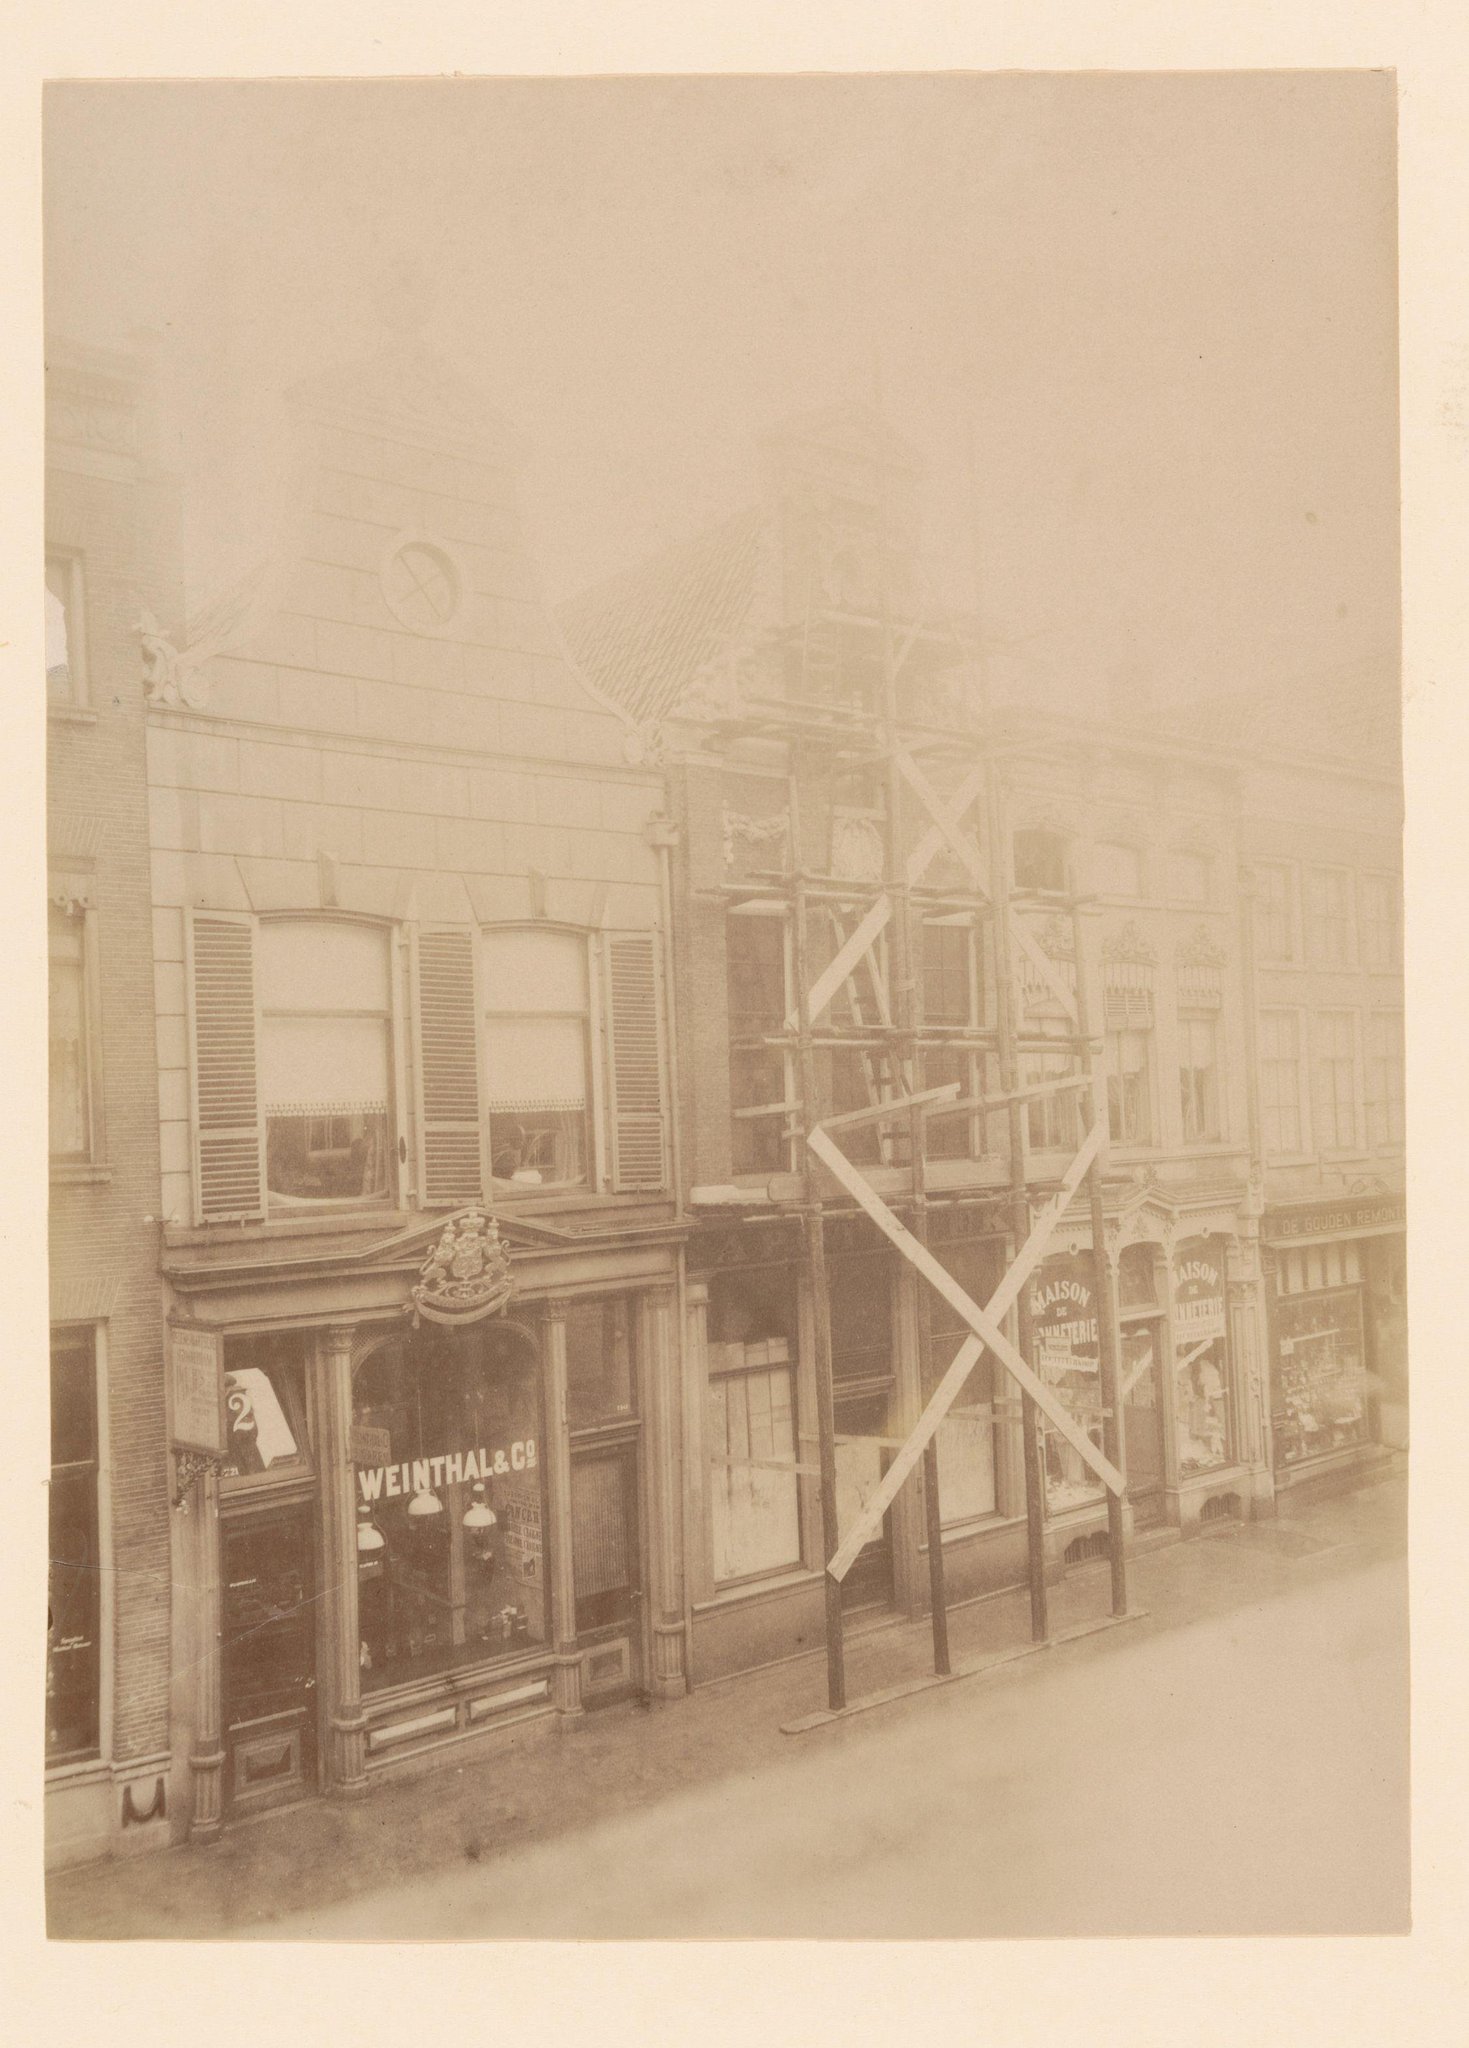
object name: photograph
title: Diezerstraat 43 te Zwolle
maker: anoniem (monumentenzorg)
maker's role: fotograaf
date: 1905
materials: cardboard, photographic support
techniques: albumen print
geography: zwolle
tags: urban housing, street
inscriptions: annotation: ‘Zwolle’, annotation: ‘Woonuis Diezerstraat 43 Zwolle (O.IJ.) Dec: 1905’